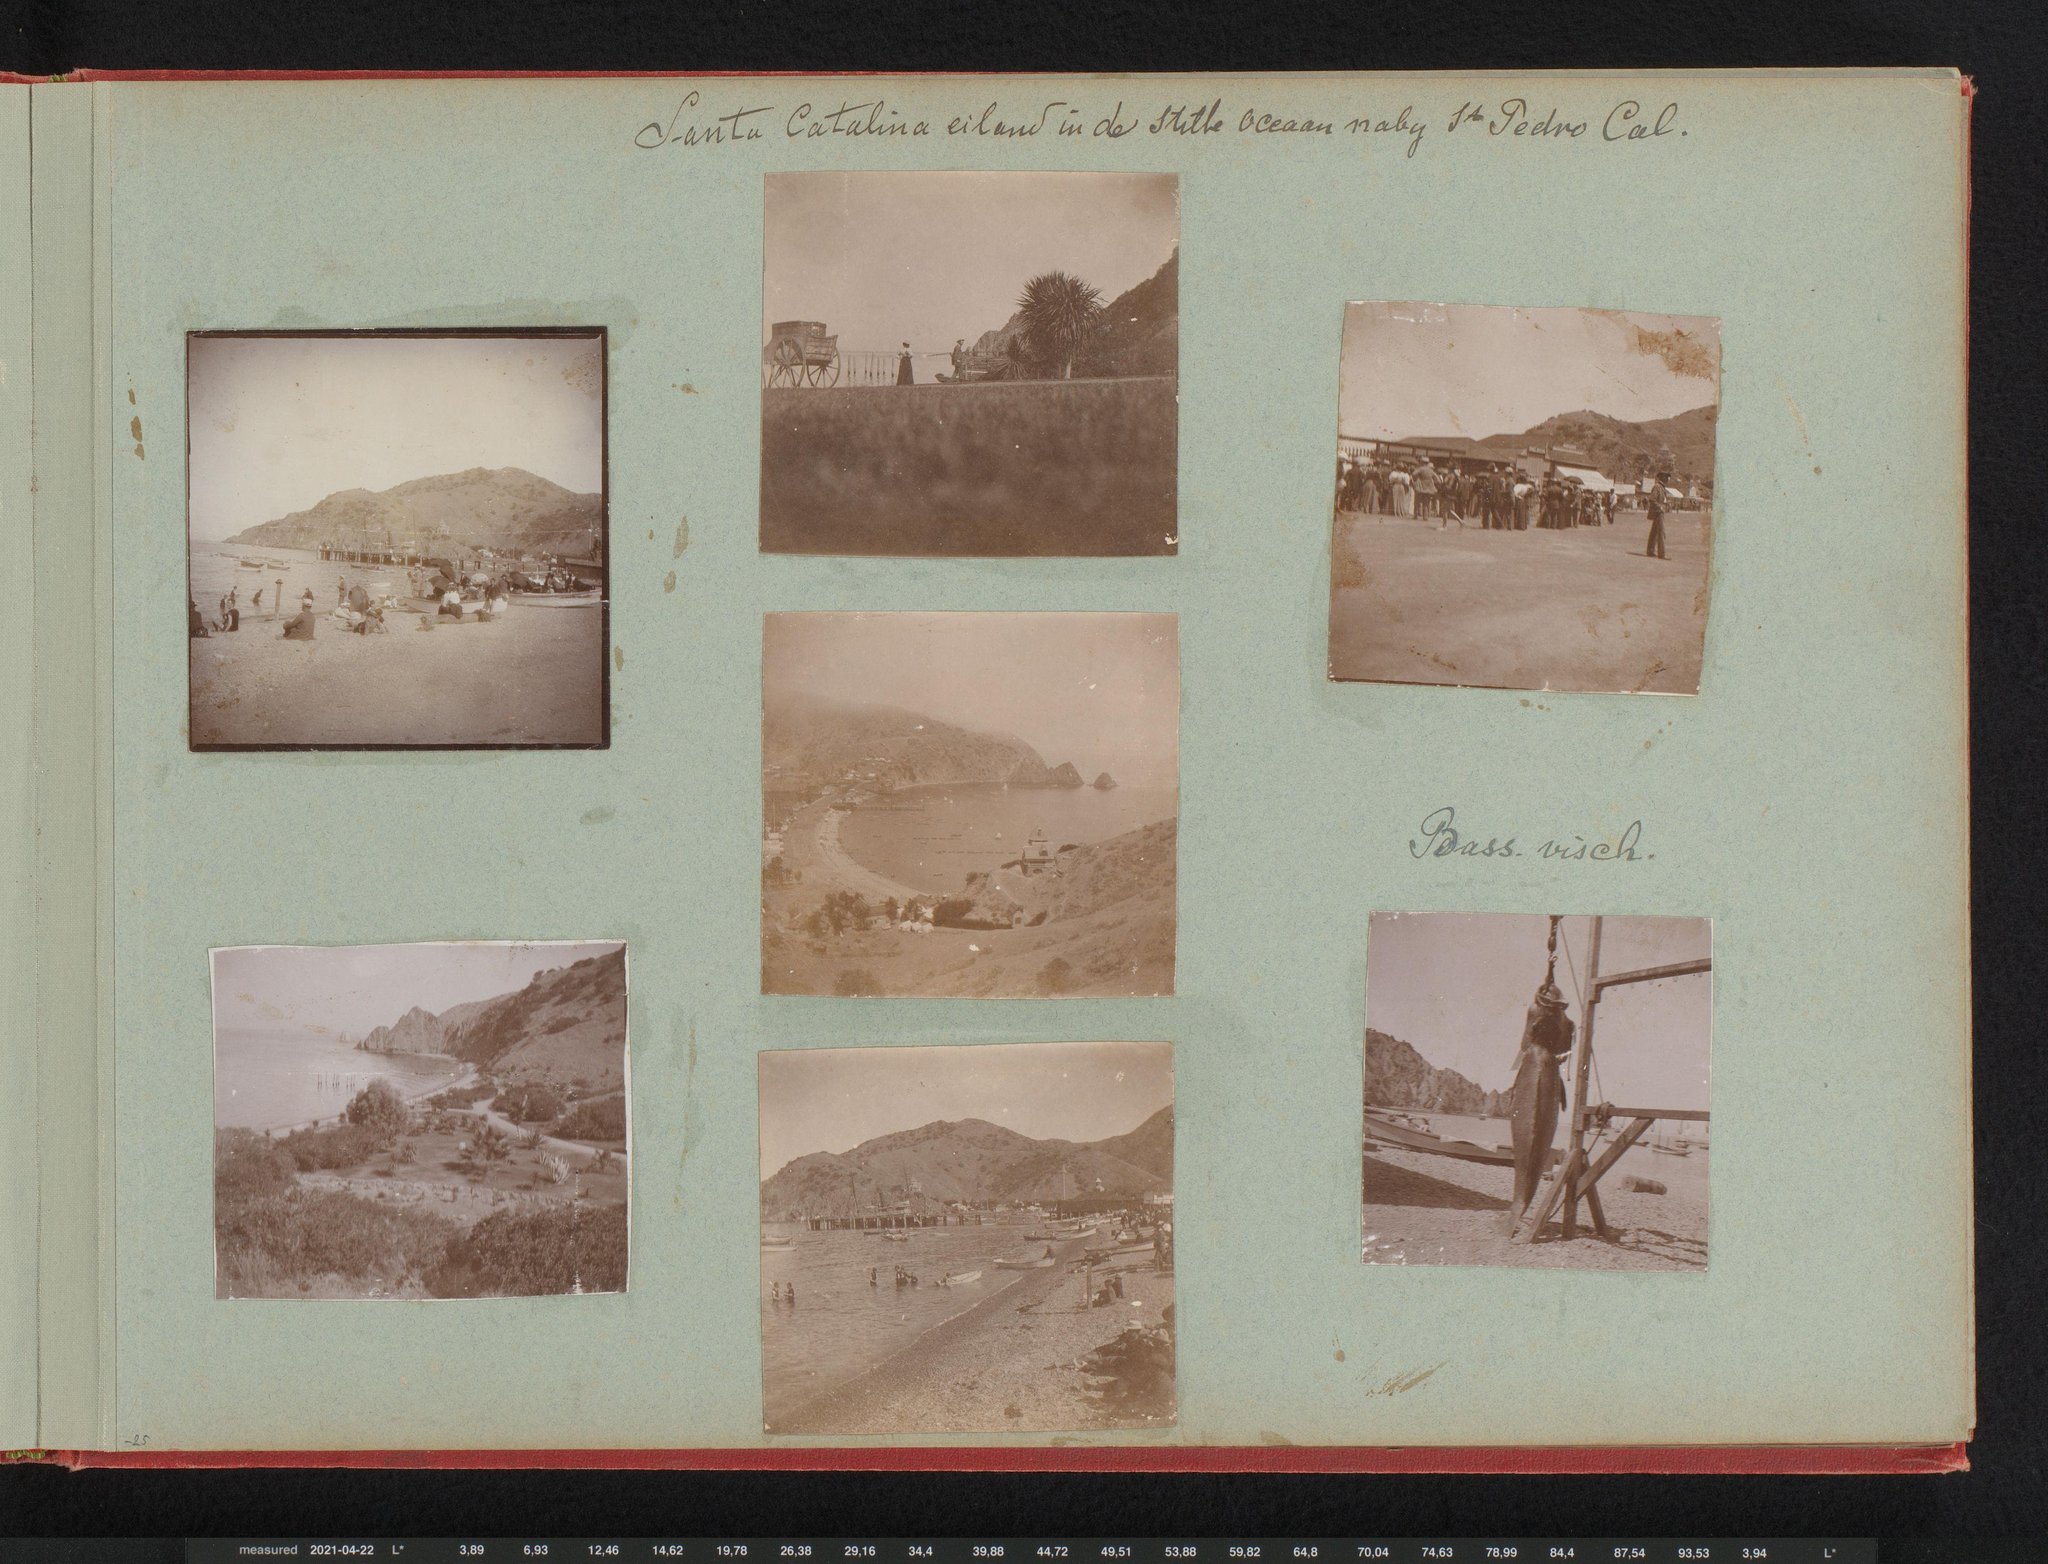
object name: album leaf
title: Gezichten aan de kust van Santa Catalina Island, Californië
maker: Anonymous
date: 1898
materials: paper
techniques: collodion silver print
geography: santa catalina island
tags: beach (as place of recreation)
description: Deze foto's zijn onderdeel van een album.